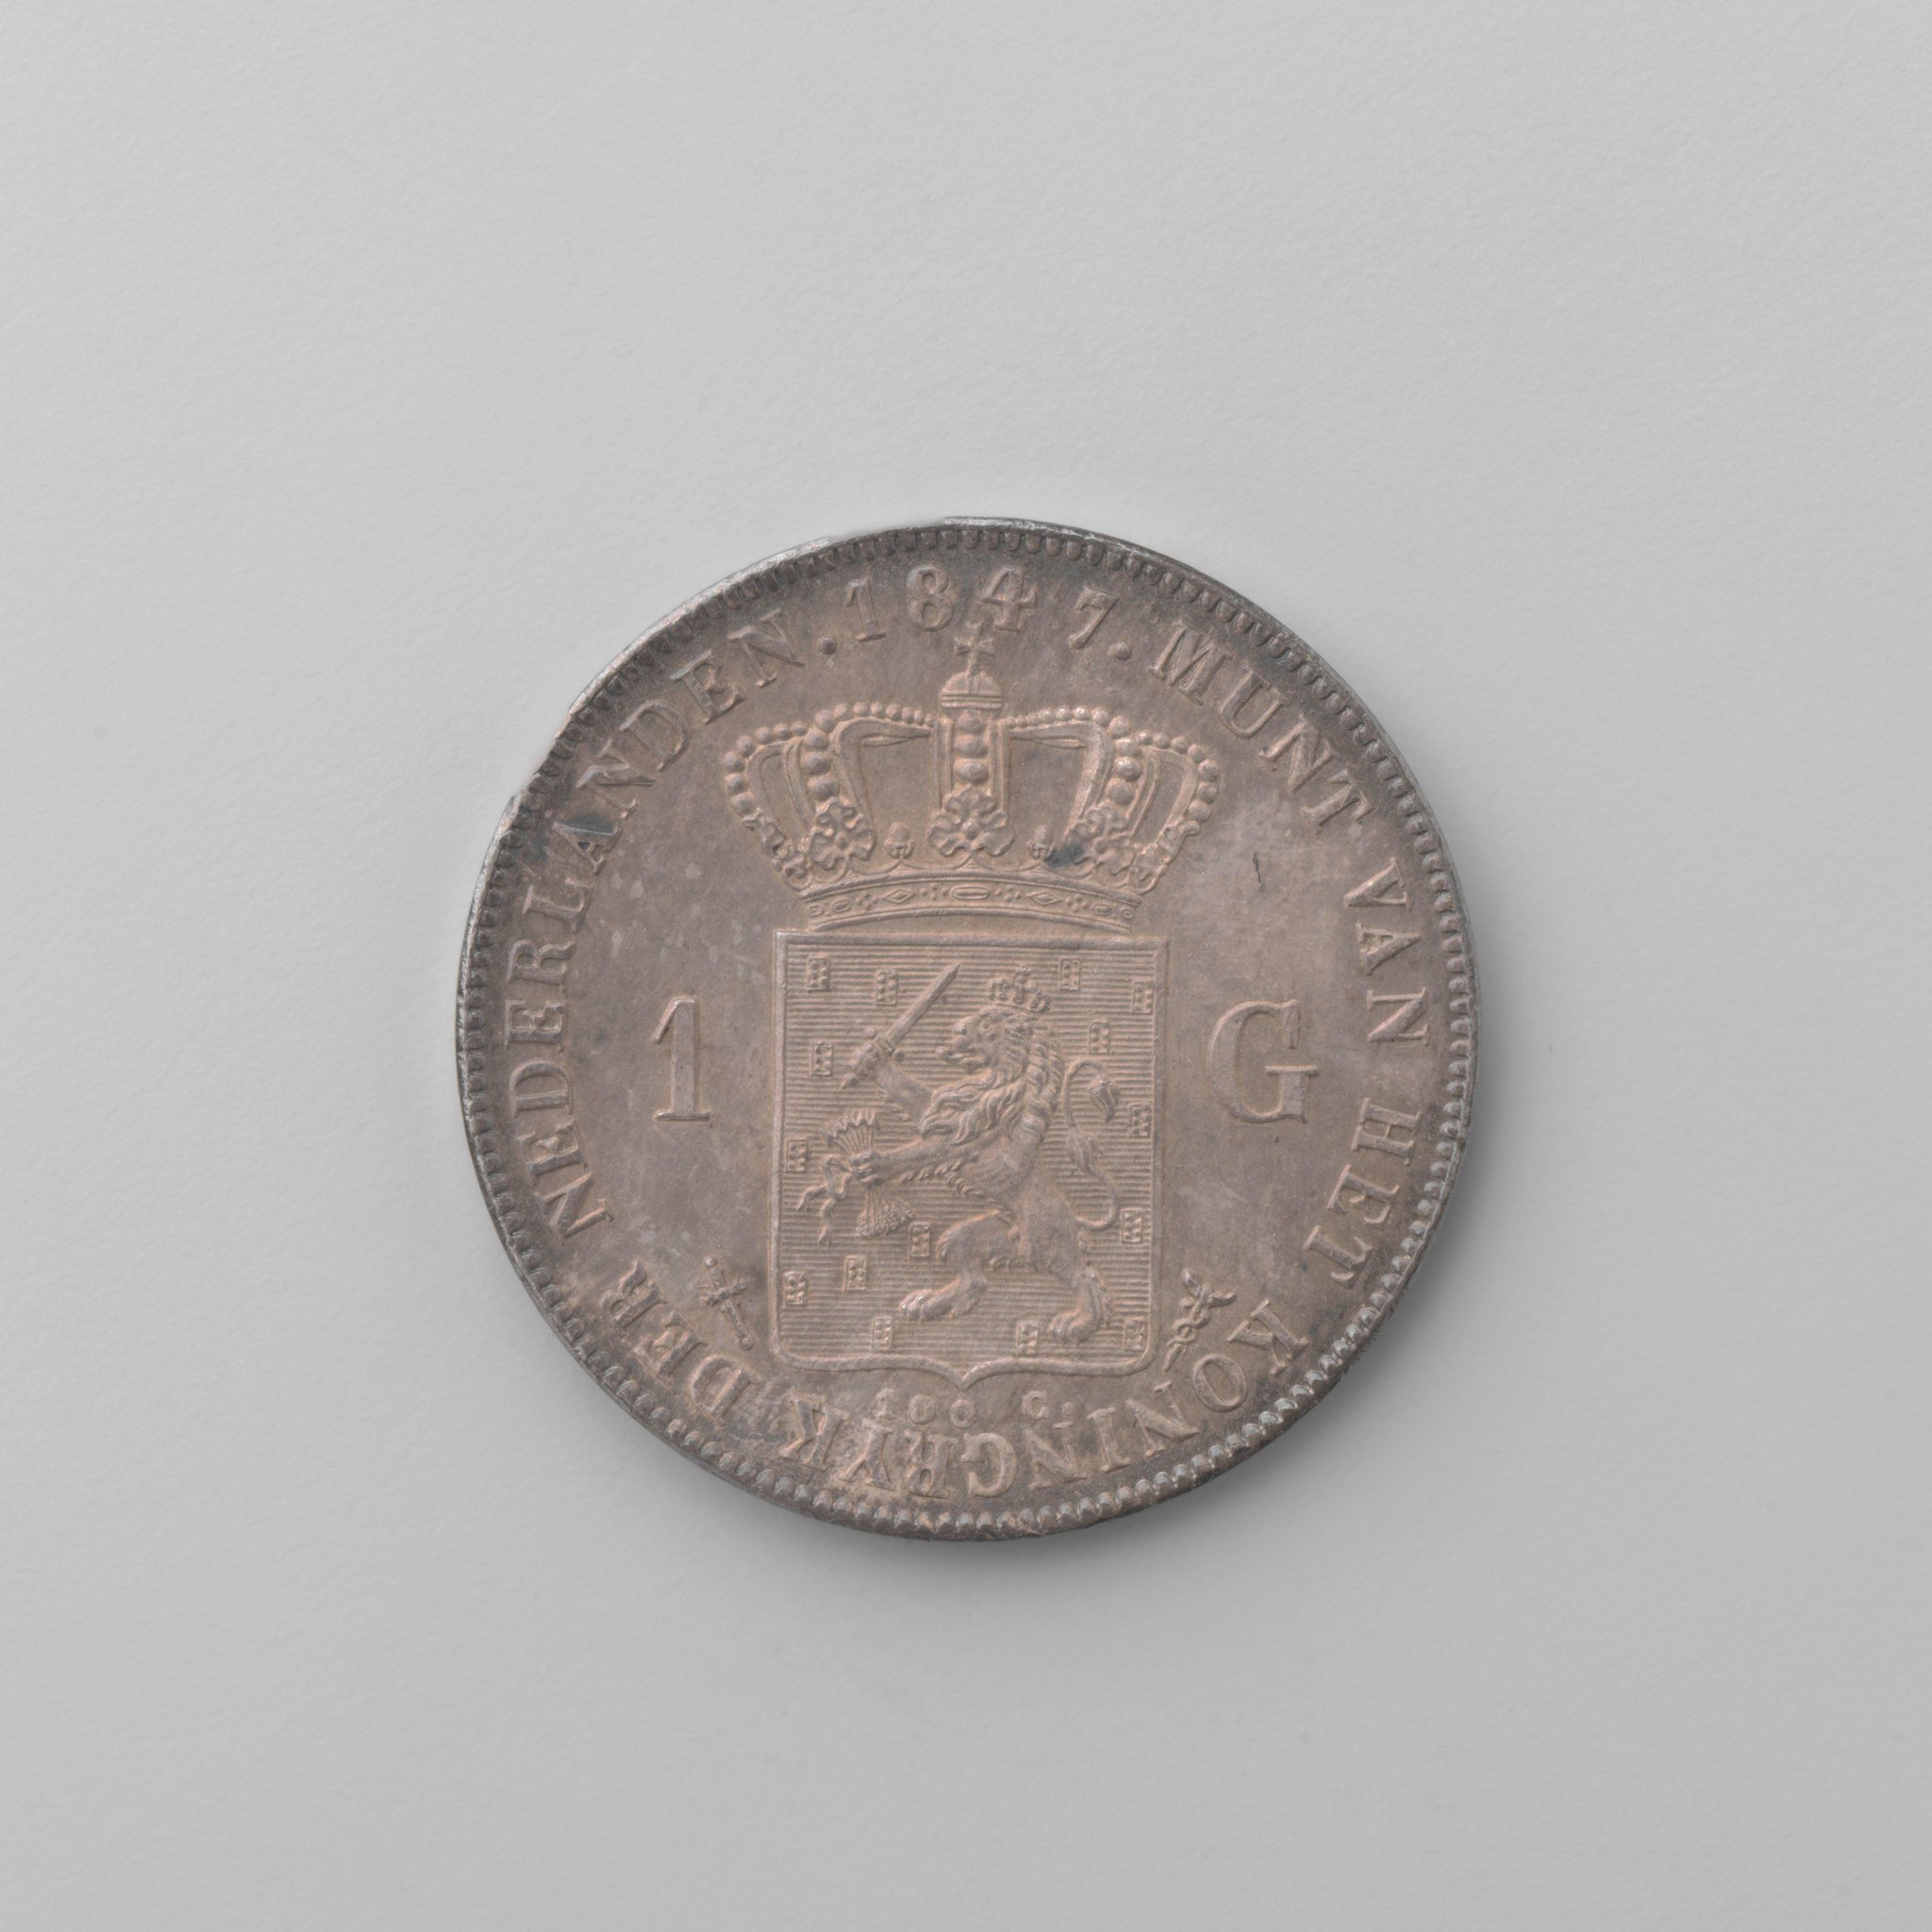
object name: coin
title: Nederlandse gulden, 1847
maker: william ii of the netherlands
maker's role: koning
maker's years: 1792-1849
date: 1847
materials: silver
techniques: striking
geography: utrecht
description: Zilveren munt. Voorzijde: borstbeeld naar links. Keerzijde: tussen waarde-aanduiding 1 G gekroond rijkswapenschild. Jaartal boven kroon. Randschrift.